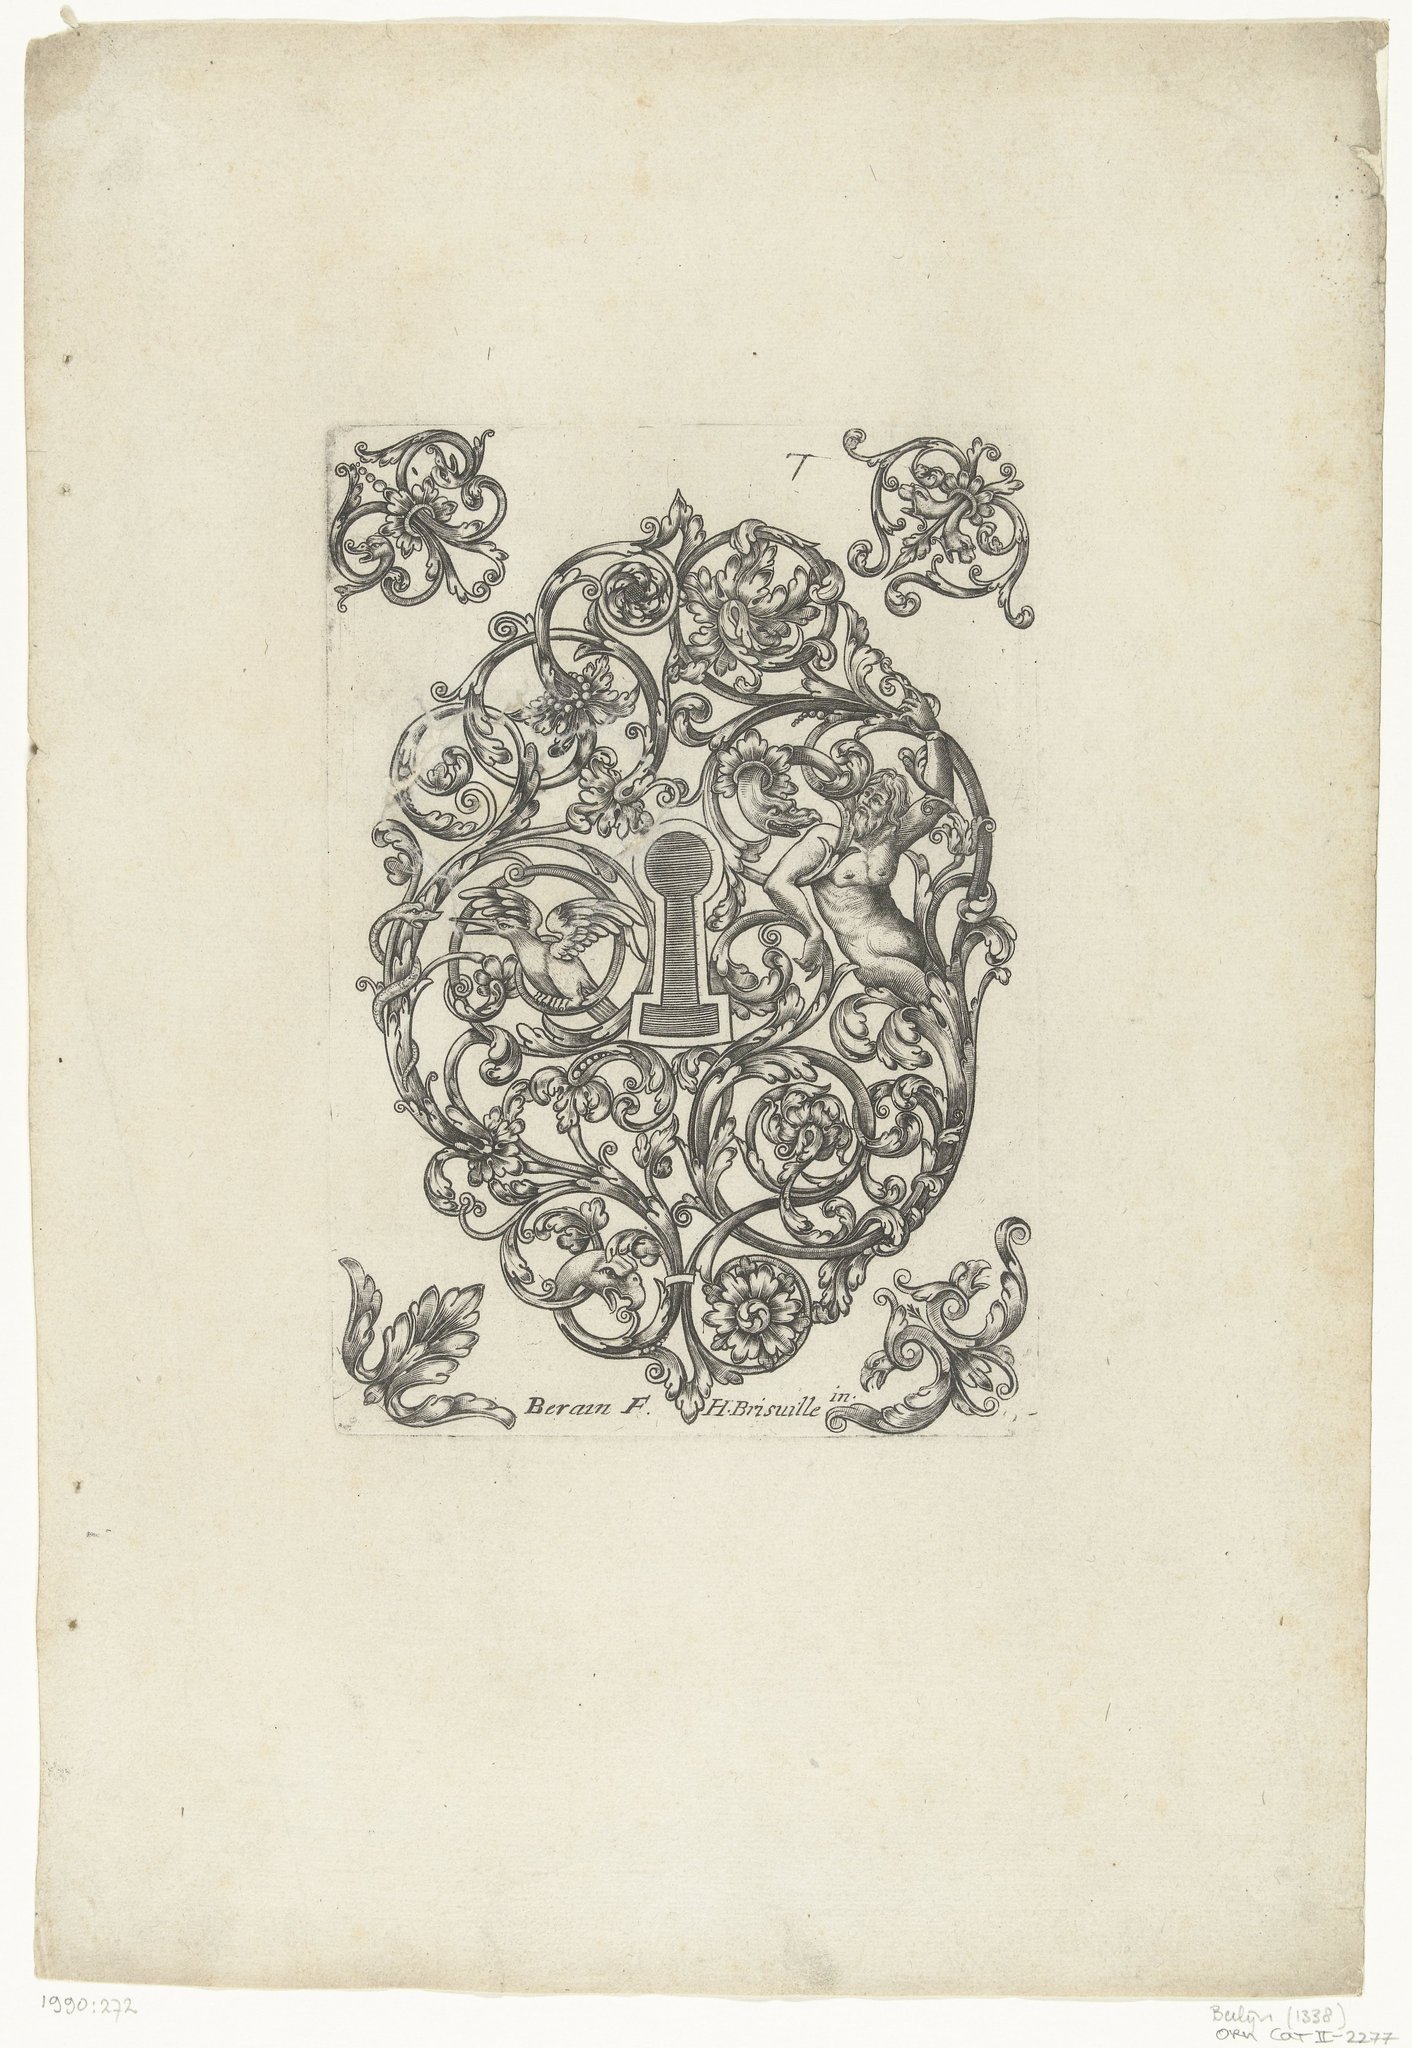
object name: ornament print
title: Diverses Pièces de Serruriers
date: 1662-1711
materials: paper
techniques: engraving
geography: france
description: Met variant voor de rechterhelft. Tussen de bladranken zit een vogel met gespreide vleugels tegenover een slang. Rechts ontspruit een man uit de bladranken. In de vier hoeken zijn kleinere ornamentele motieven afgebeeld. Blad 7 uit serie van titelblad, blad met opdracht en 14 bladen met beslag en smeedwerk, sleutelgatplaten, sleutels, deurkloppers en deurknoppen. Tweede editie.